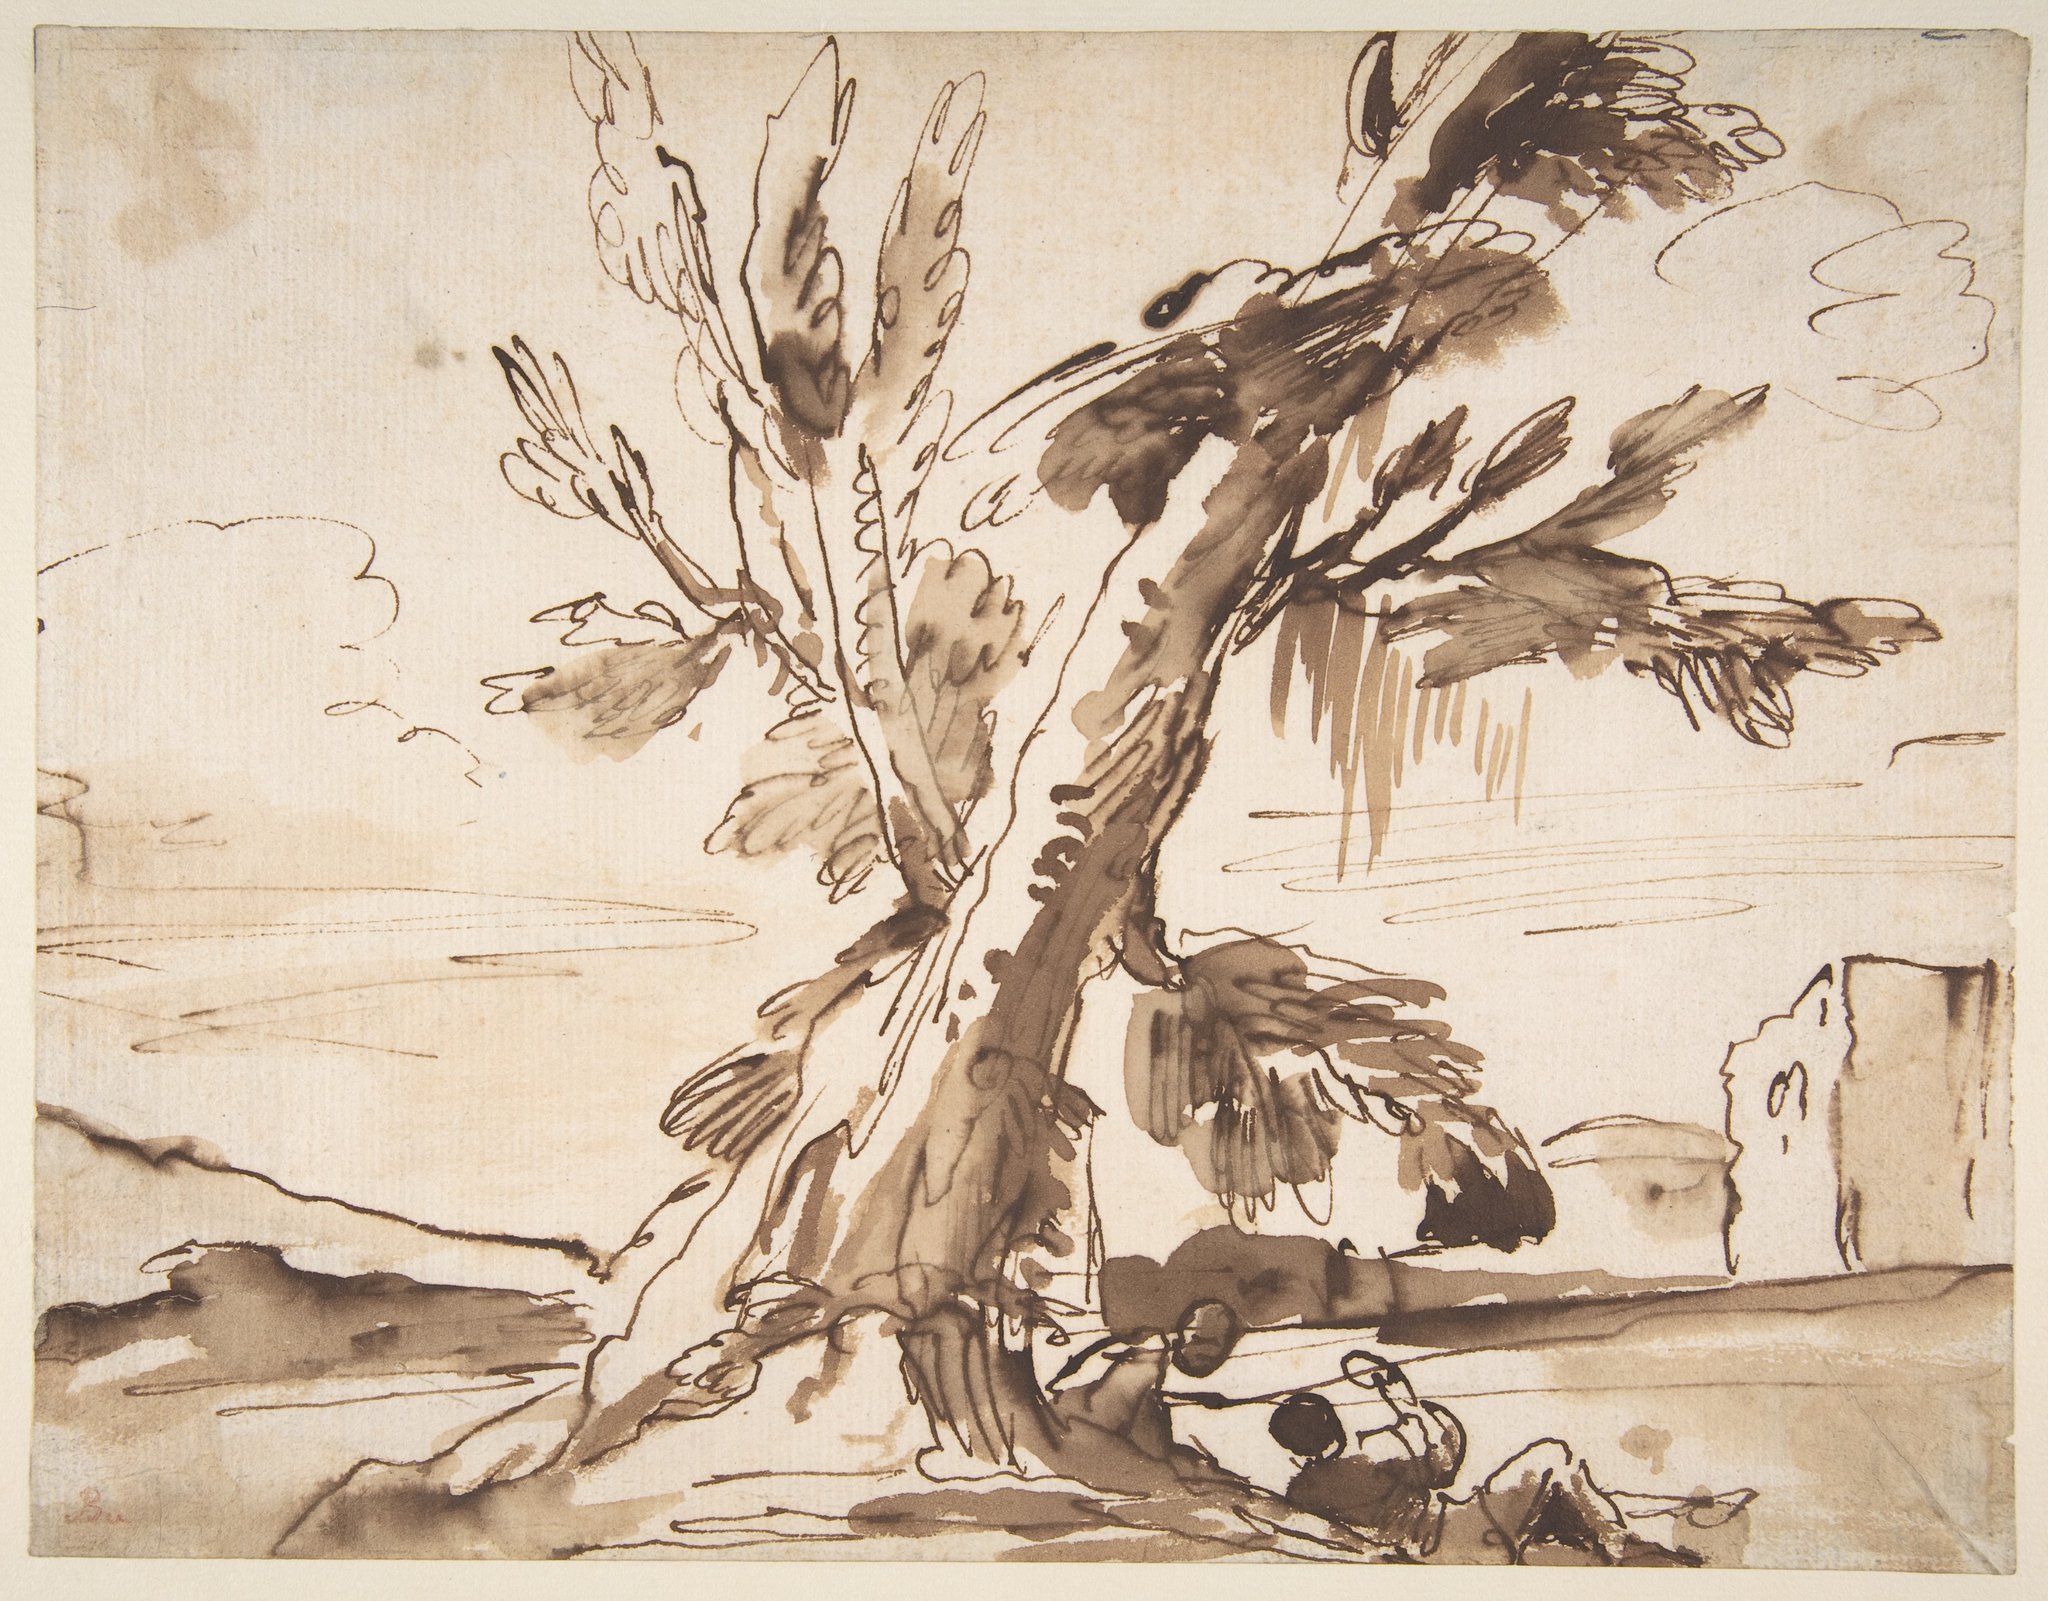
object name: drawing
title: Landscape with Two Men Under a Tree.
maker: pier francesco mola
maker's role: artist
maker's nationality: italian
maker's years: 1612-1666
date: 1612-1666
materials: ink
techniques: brush, pen, wash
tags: men,landscapes,trees